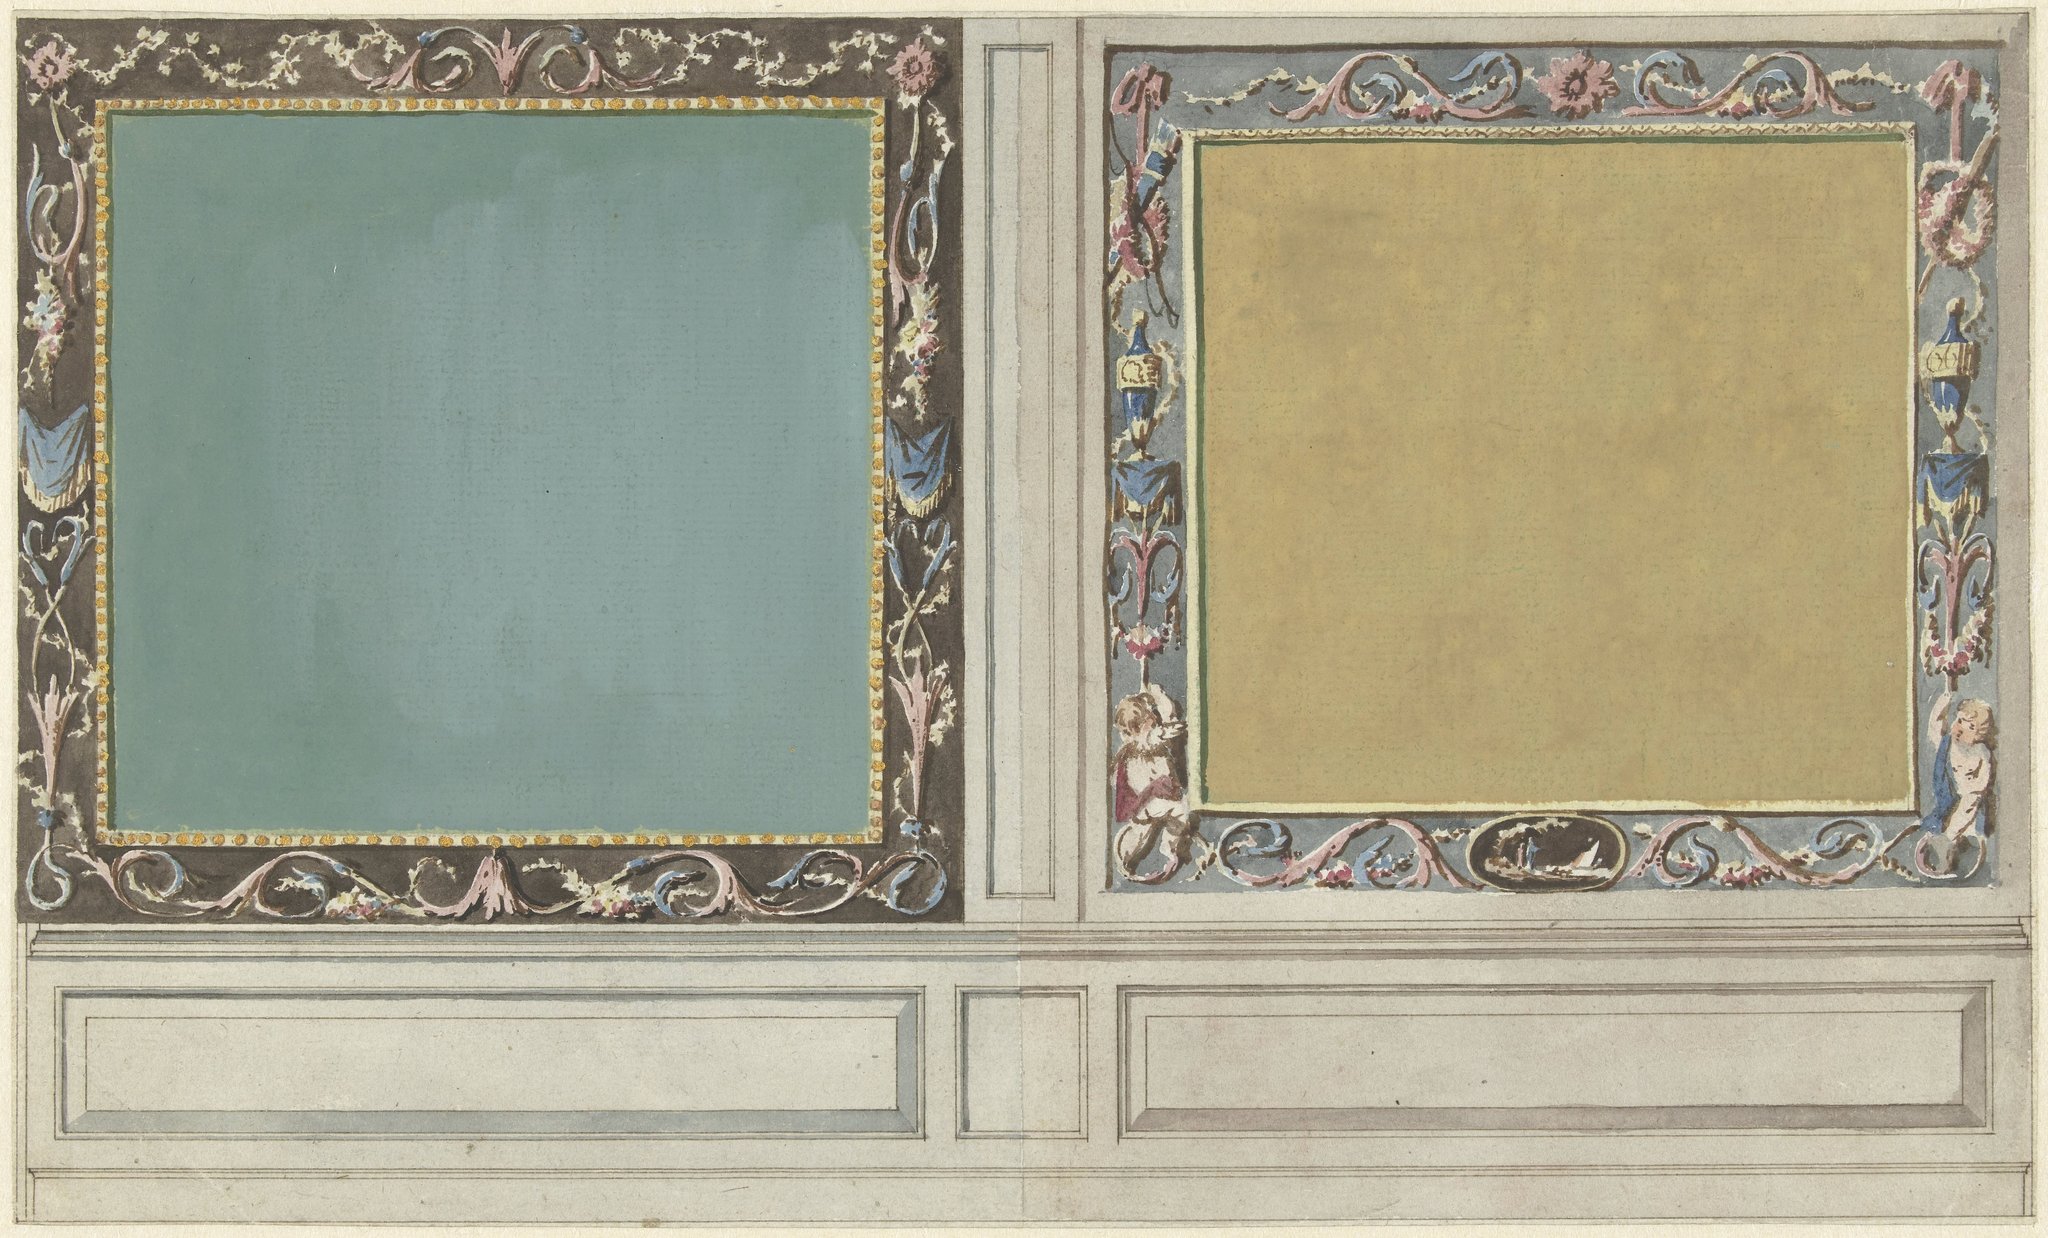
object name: drawing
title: Ontwerp voor kamerversiering met twee rechthoekige panelen in geel en groen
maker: abraham meertens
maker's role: draughtsman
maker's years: 1757-1823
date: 1767-1823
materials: paint, ink, paper, pencil, watercolor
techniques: brush, pen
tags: wall-covering